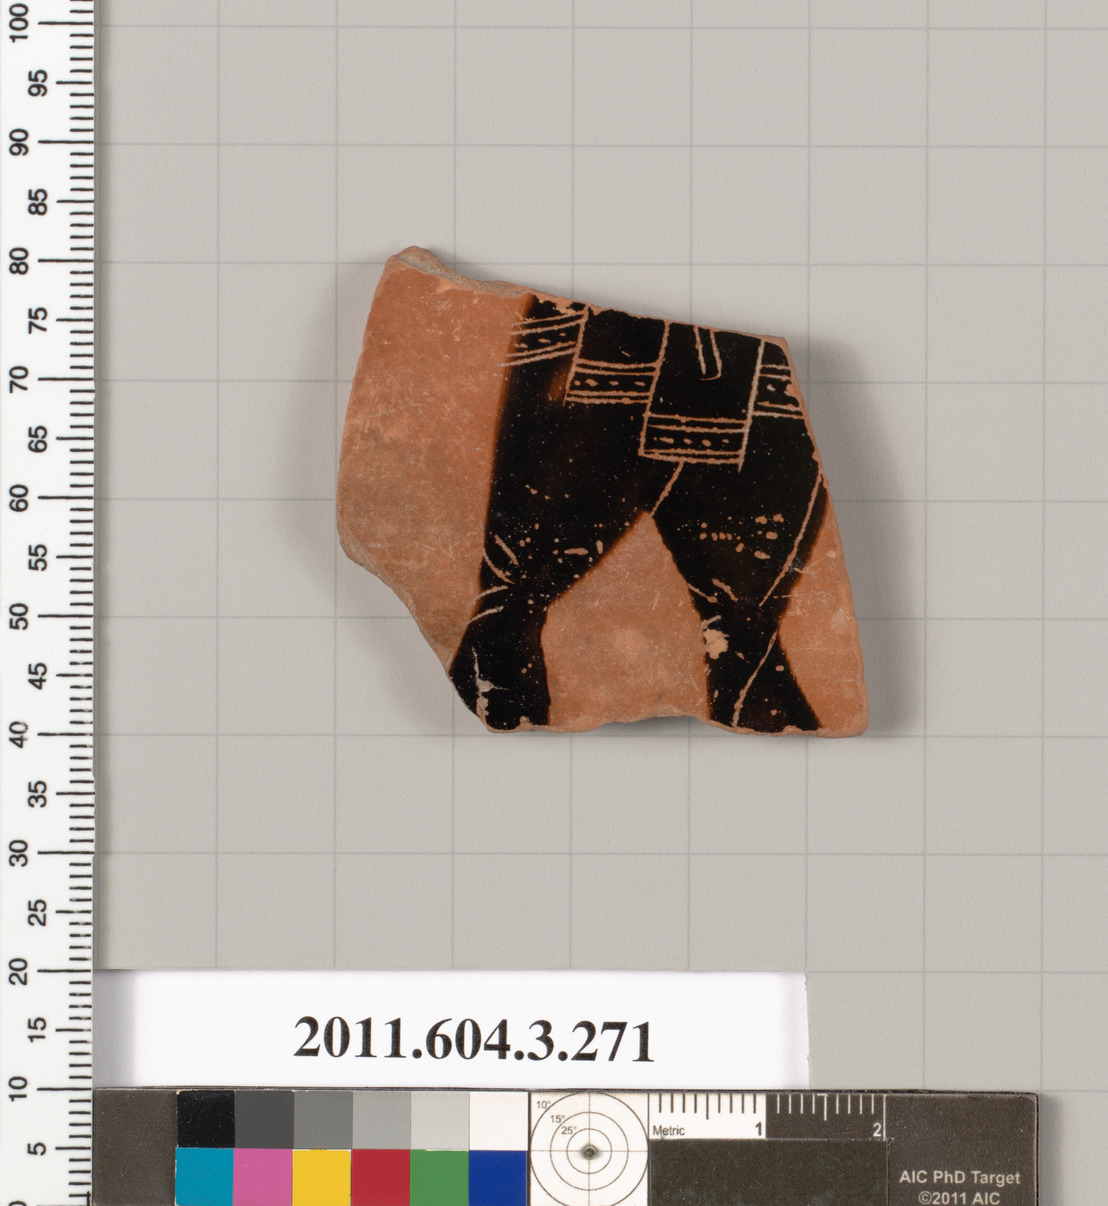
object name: neck amphora fragment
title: Terracotta fragment of a neck-amphora (jar)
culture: greek, attic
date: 540-520 BCE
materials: terracotta